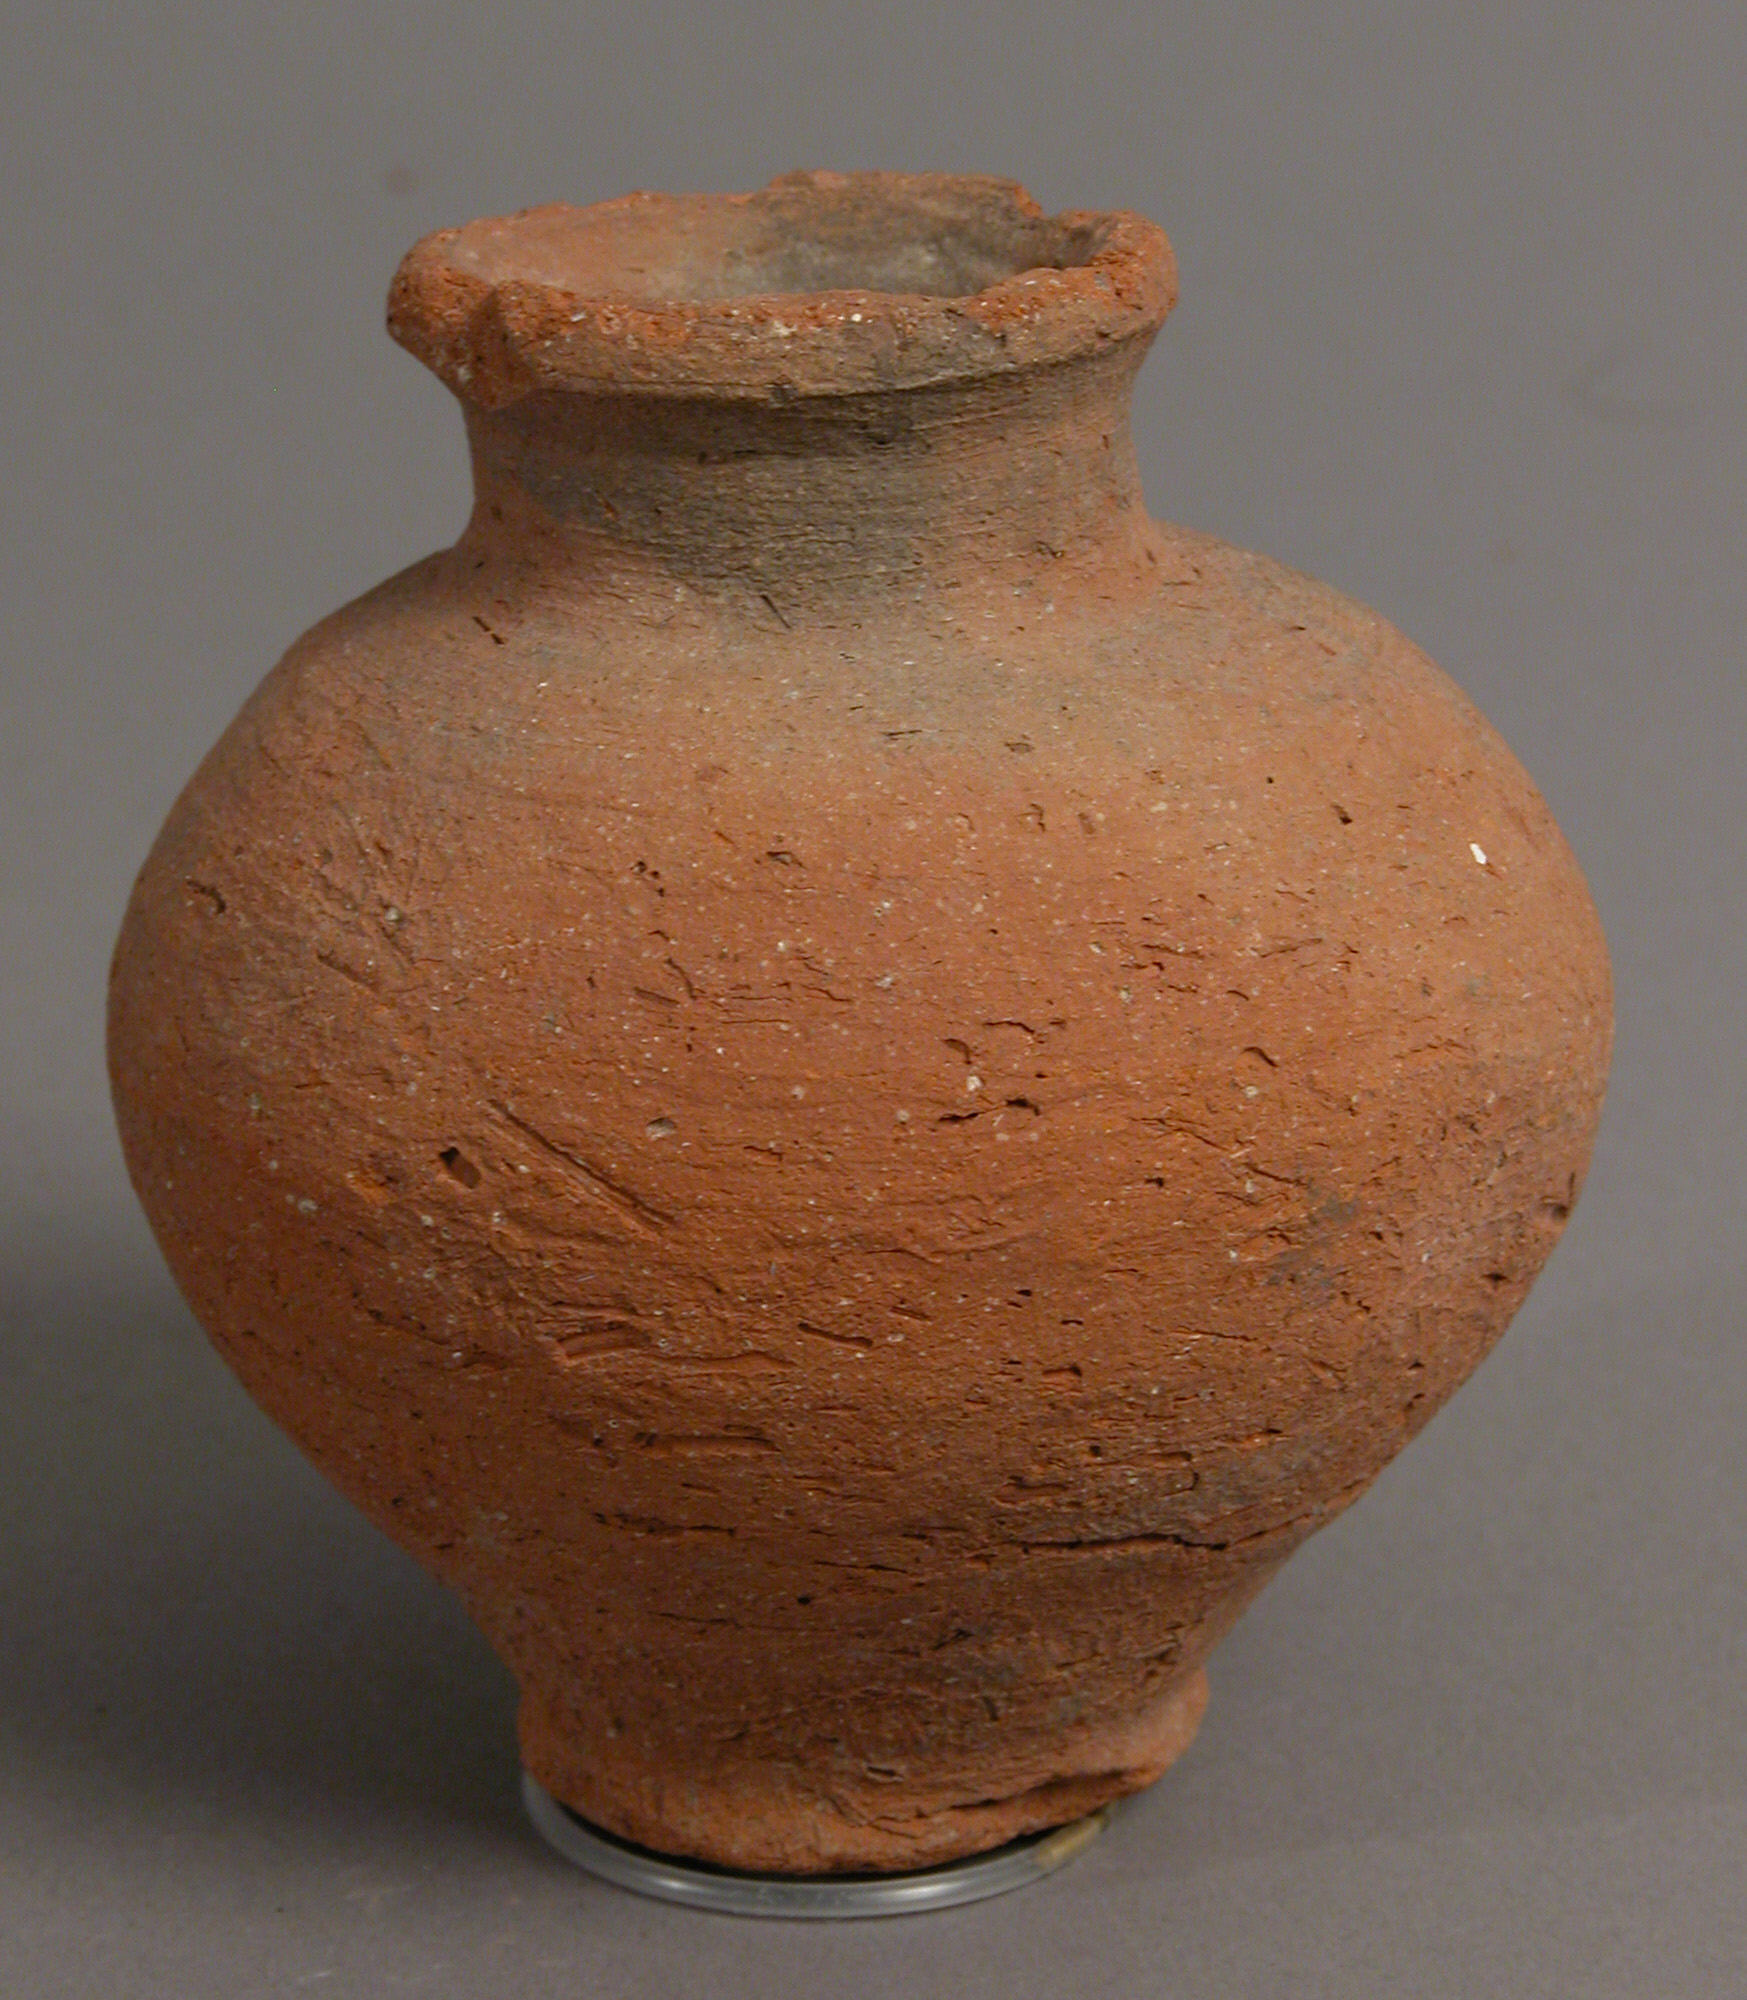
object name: pot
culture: coptic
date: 301-700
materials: earthenware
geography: egypt